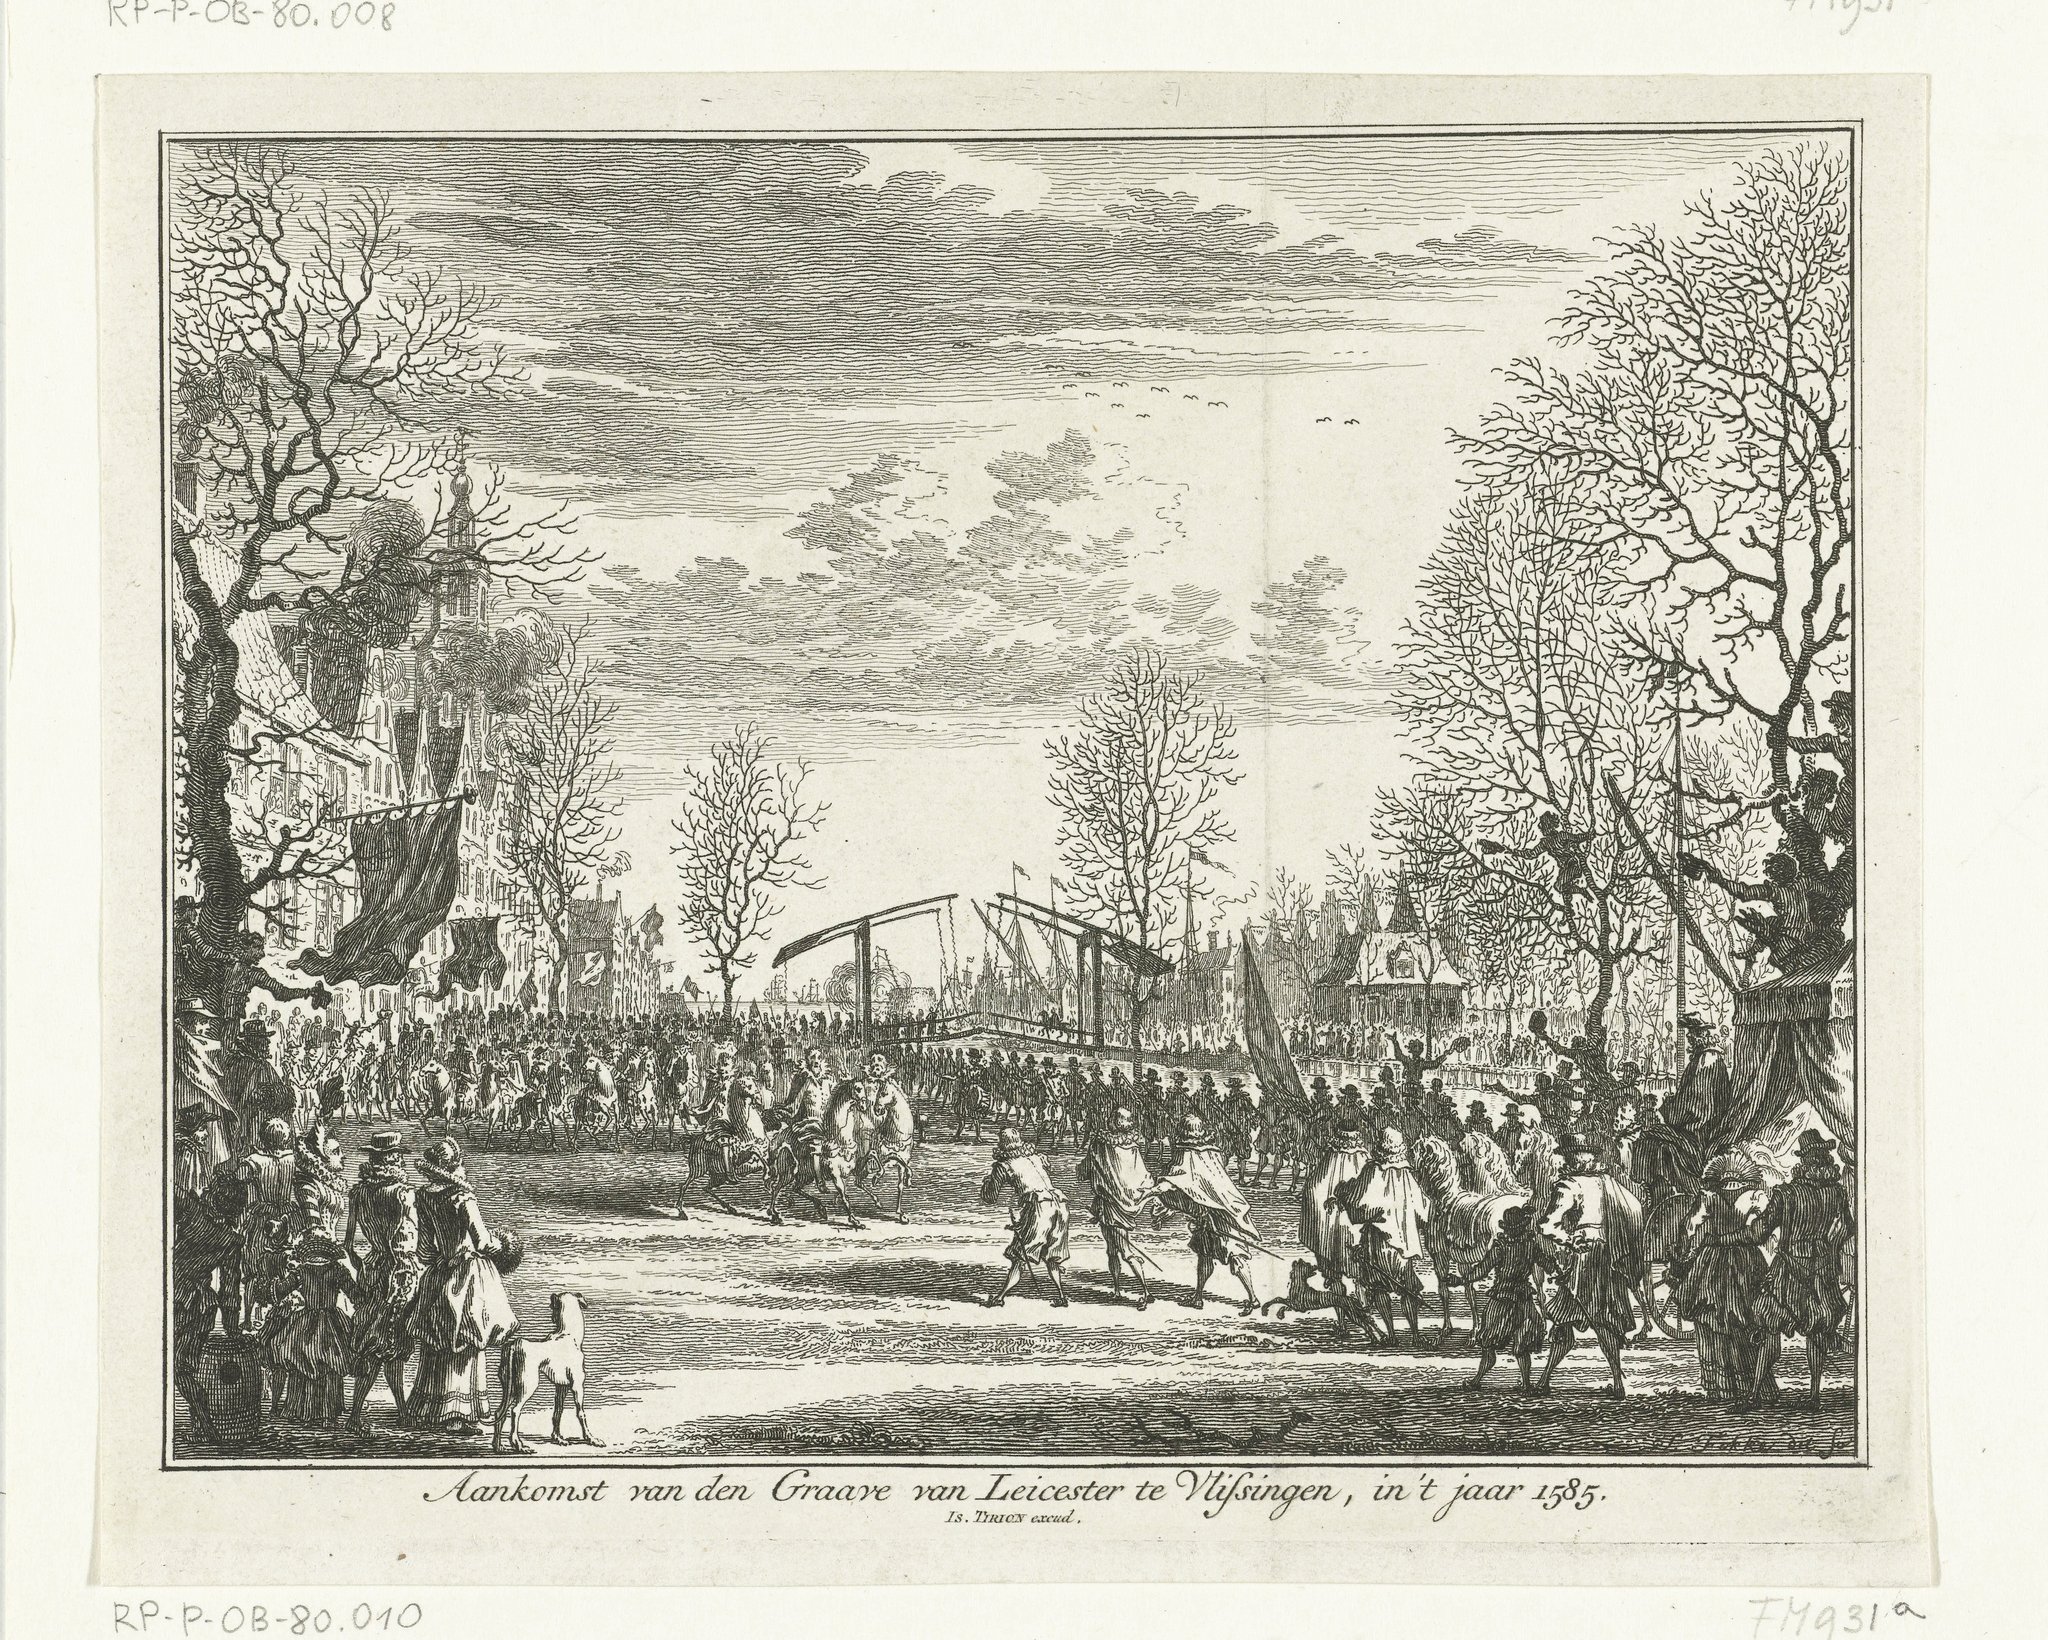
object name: print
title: Aankomst van den Graave van Leicester te Vlissingen, in 't jaar 1585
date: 1753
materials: paper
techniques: etching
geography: northern netherlands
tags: robert dudley (1st earl of leicester), flushing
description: Aankomst van Robert Dudley, graaf van Leicester, in Vlissingen op 20 december 1585. Ontvangst van de graaf op de kade door een grote menigte.